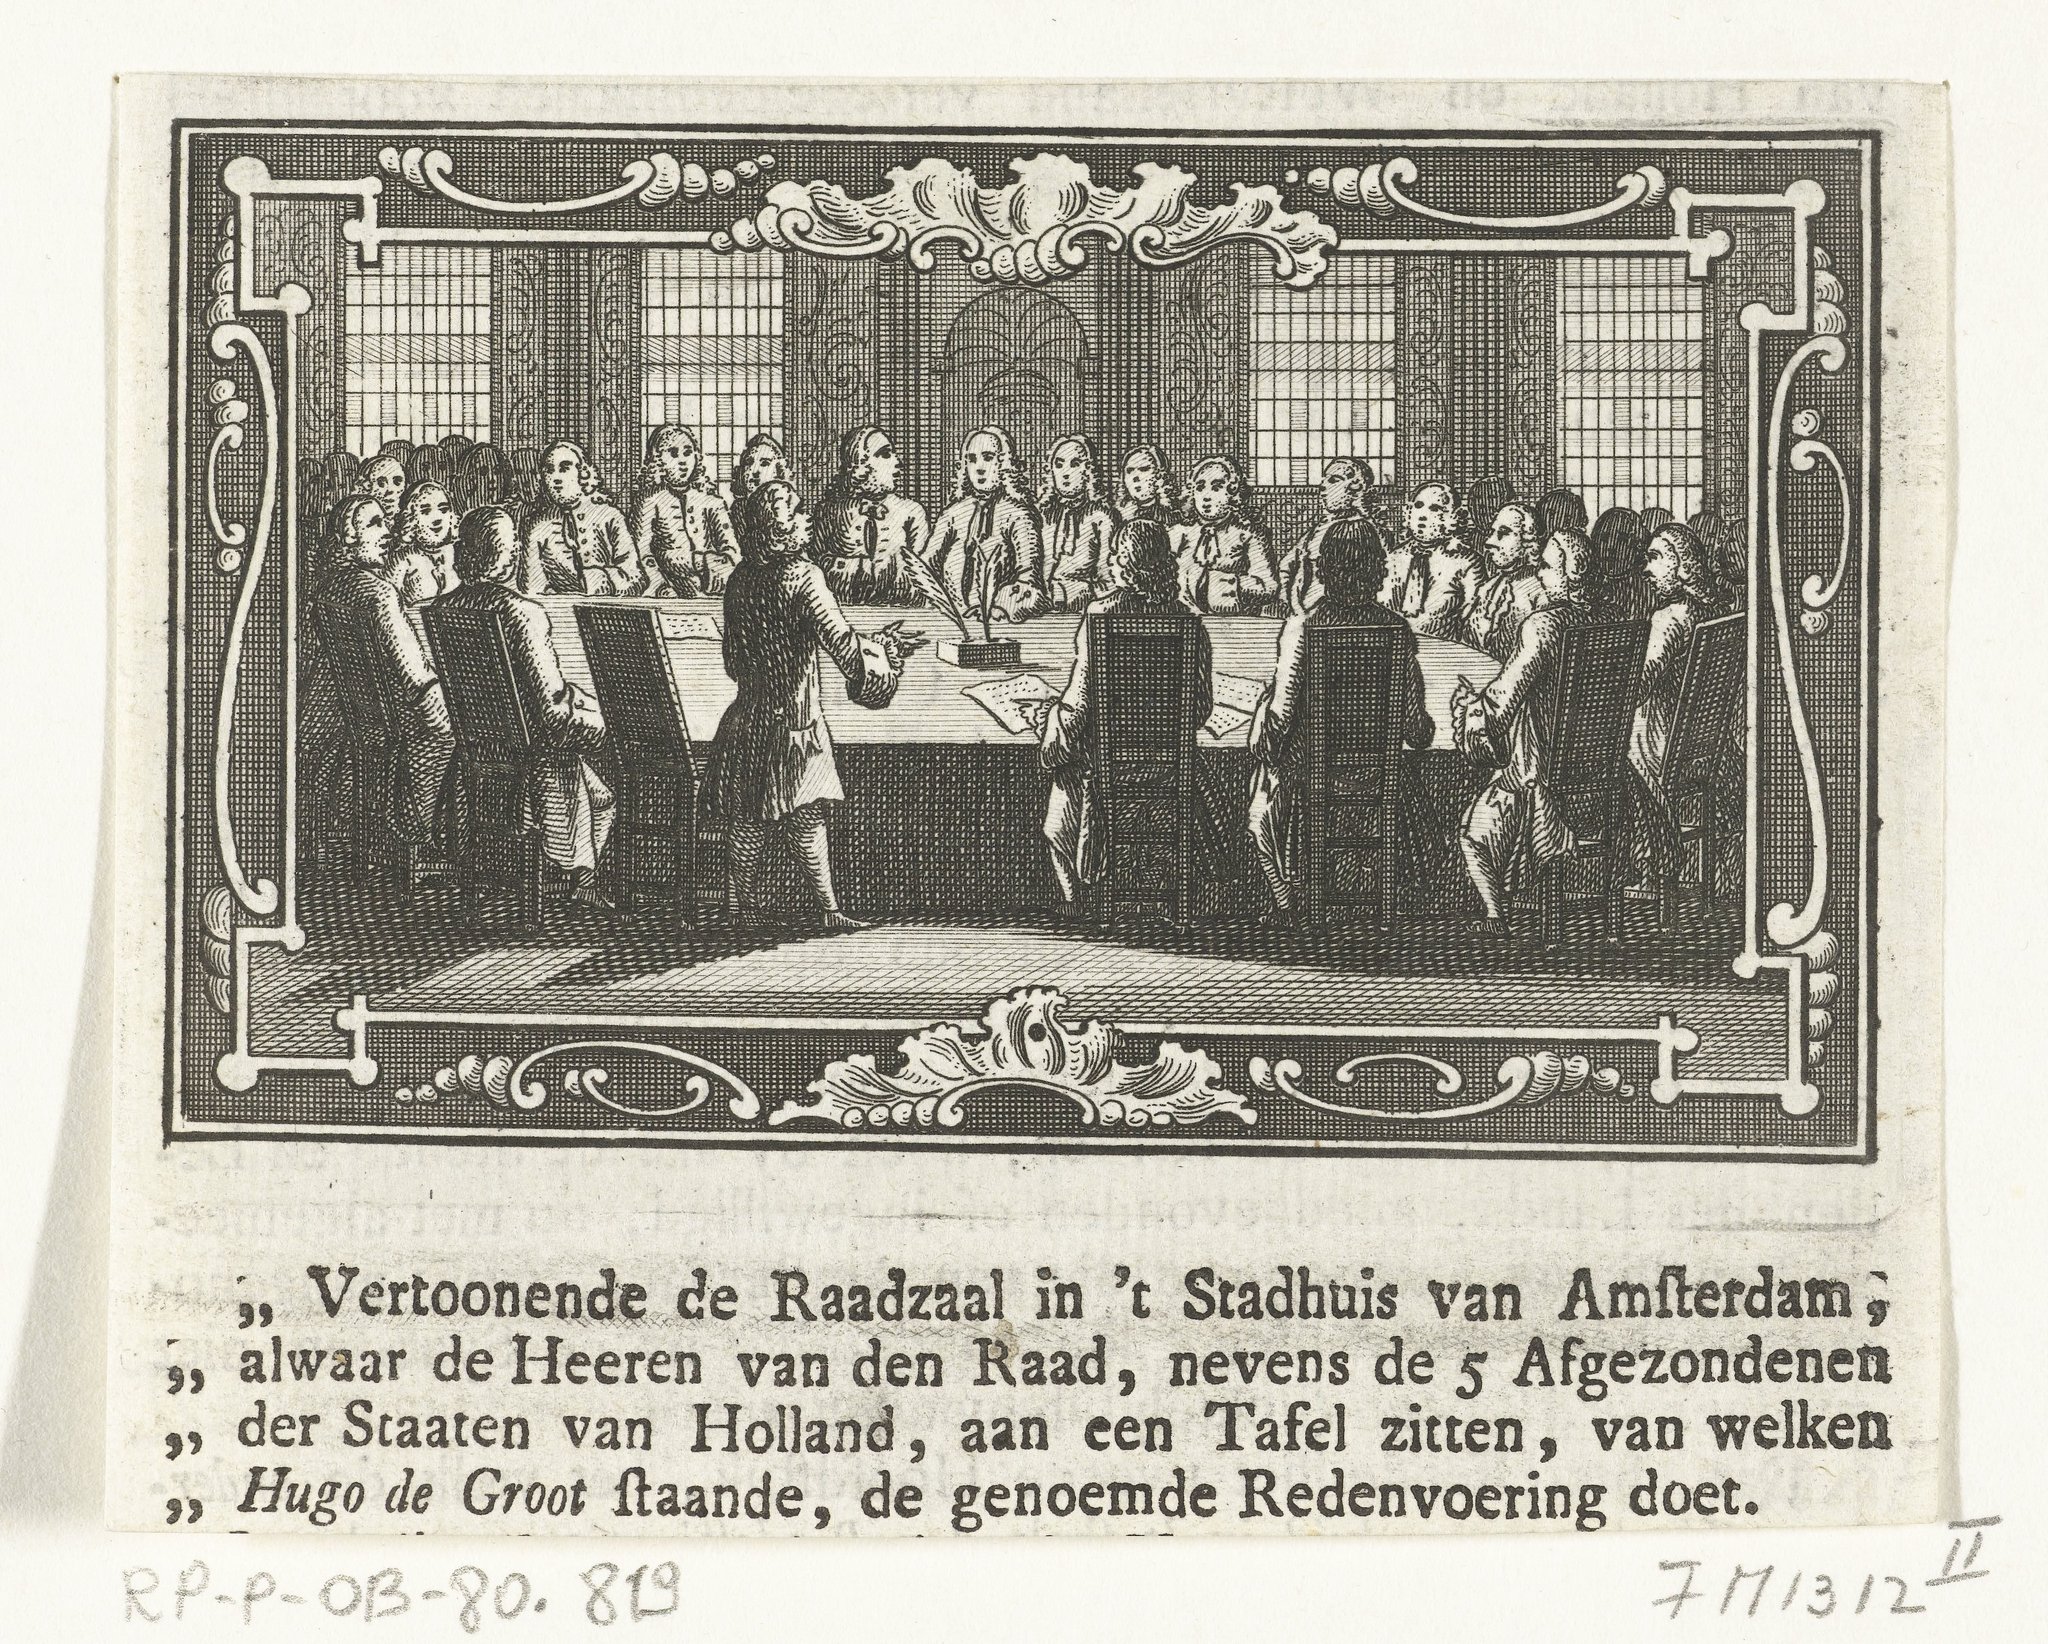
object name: history print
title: Vertoonende de Raadzaal in 't Stadhuis van Amsterdam; alwaar de Heeren van den Raad, nevens de 5 Afgezondenen der Staaten van Holland, aan een Tafel zitten, van welken Hugo de Groot staande, de genoemde Redenvoering doet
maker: Anonymous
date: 1700-1799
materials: paper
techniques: etching, letterpress printing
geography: netherlands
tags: delft, hugo de groot, plea, defence, amsterdam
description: Hugo de Groot pleit in de Amsterdamse vroedschap namens de remonstranten tevergeefs voor tolerantie, 1616. Voorstelling in decoratieve omlijsting, bedrukt op achterzijde met tekst in het Nederlands.